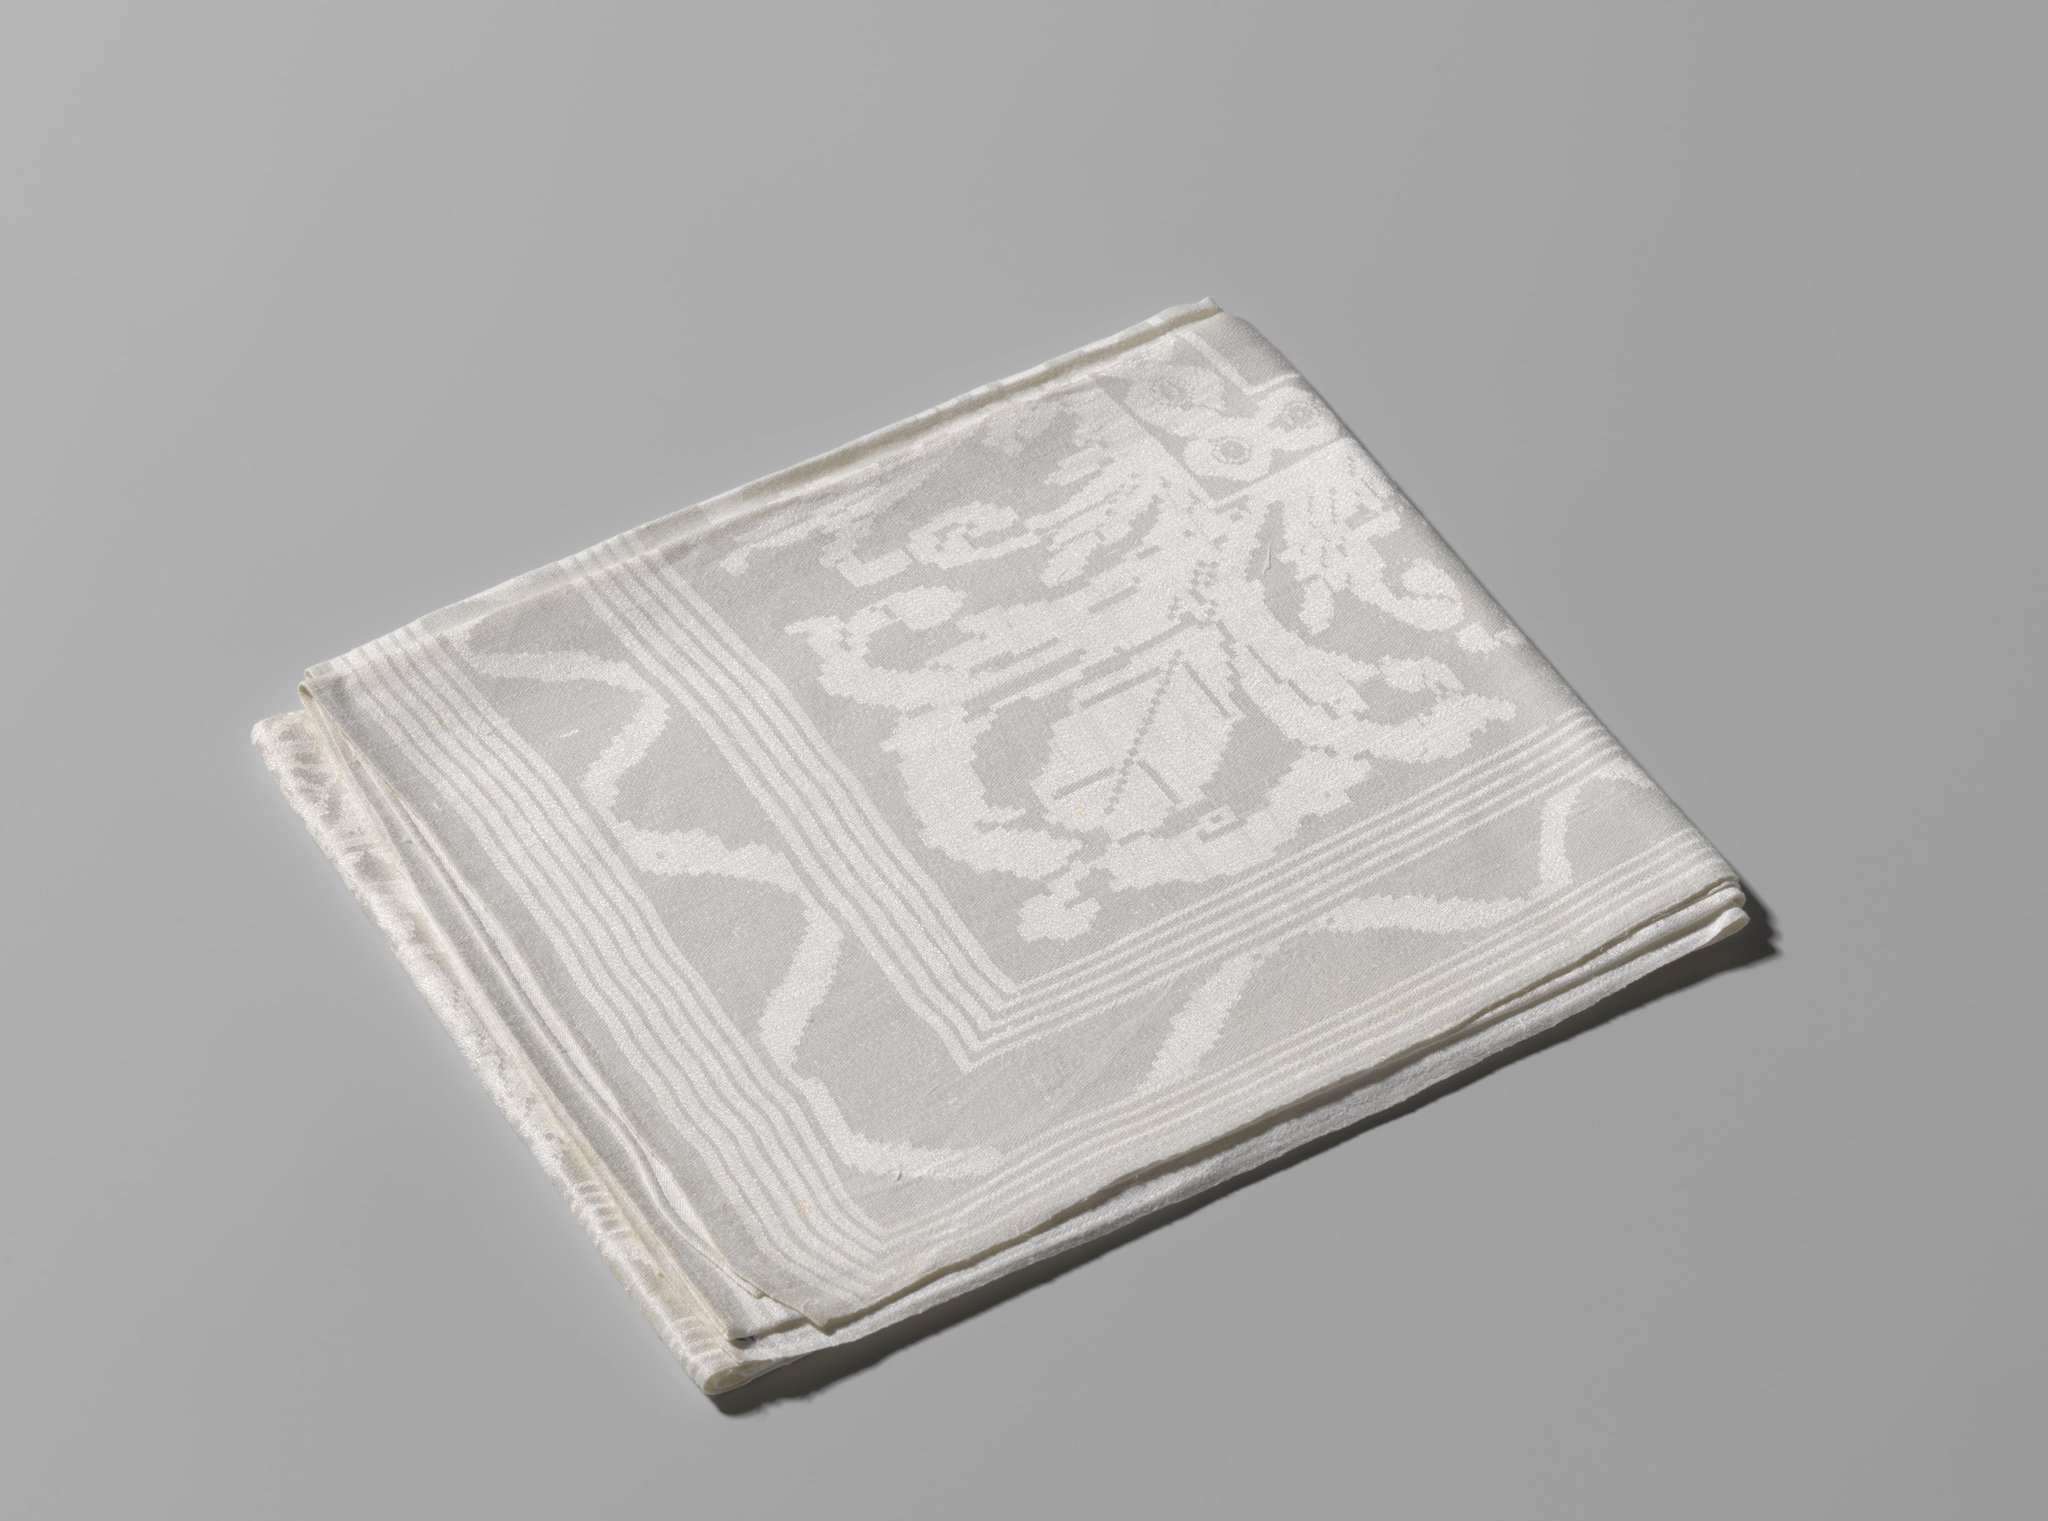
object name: napkin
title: Servet van damast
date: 1757-1800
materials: linen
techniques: damask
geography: northern netherlands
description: Damasten servet met het wapen Quack, gemerkt QW 18.